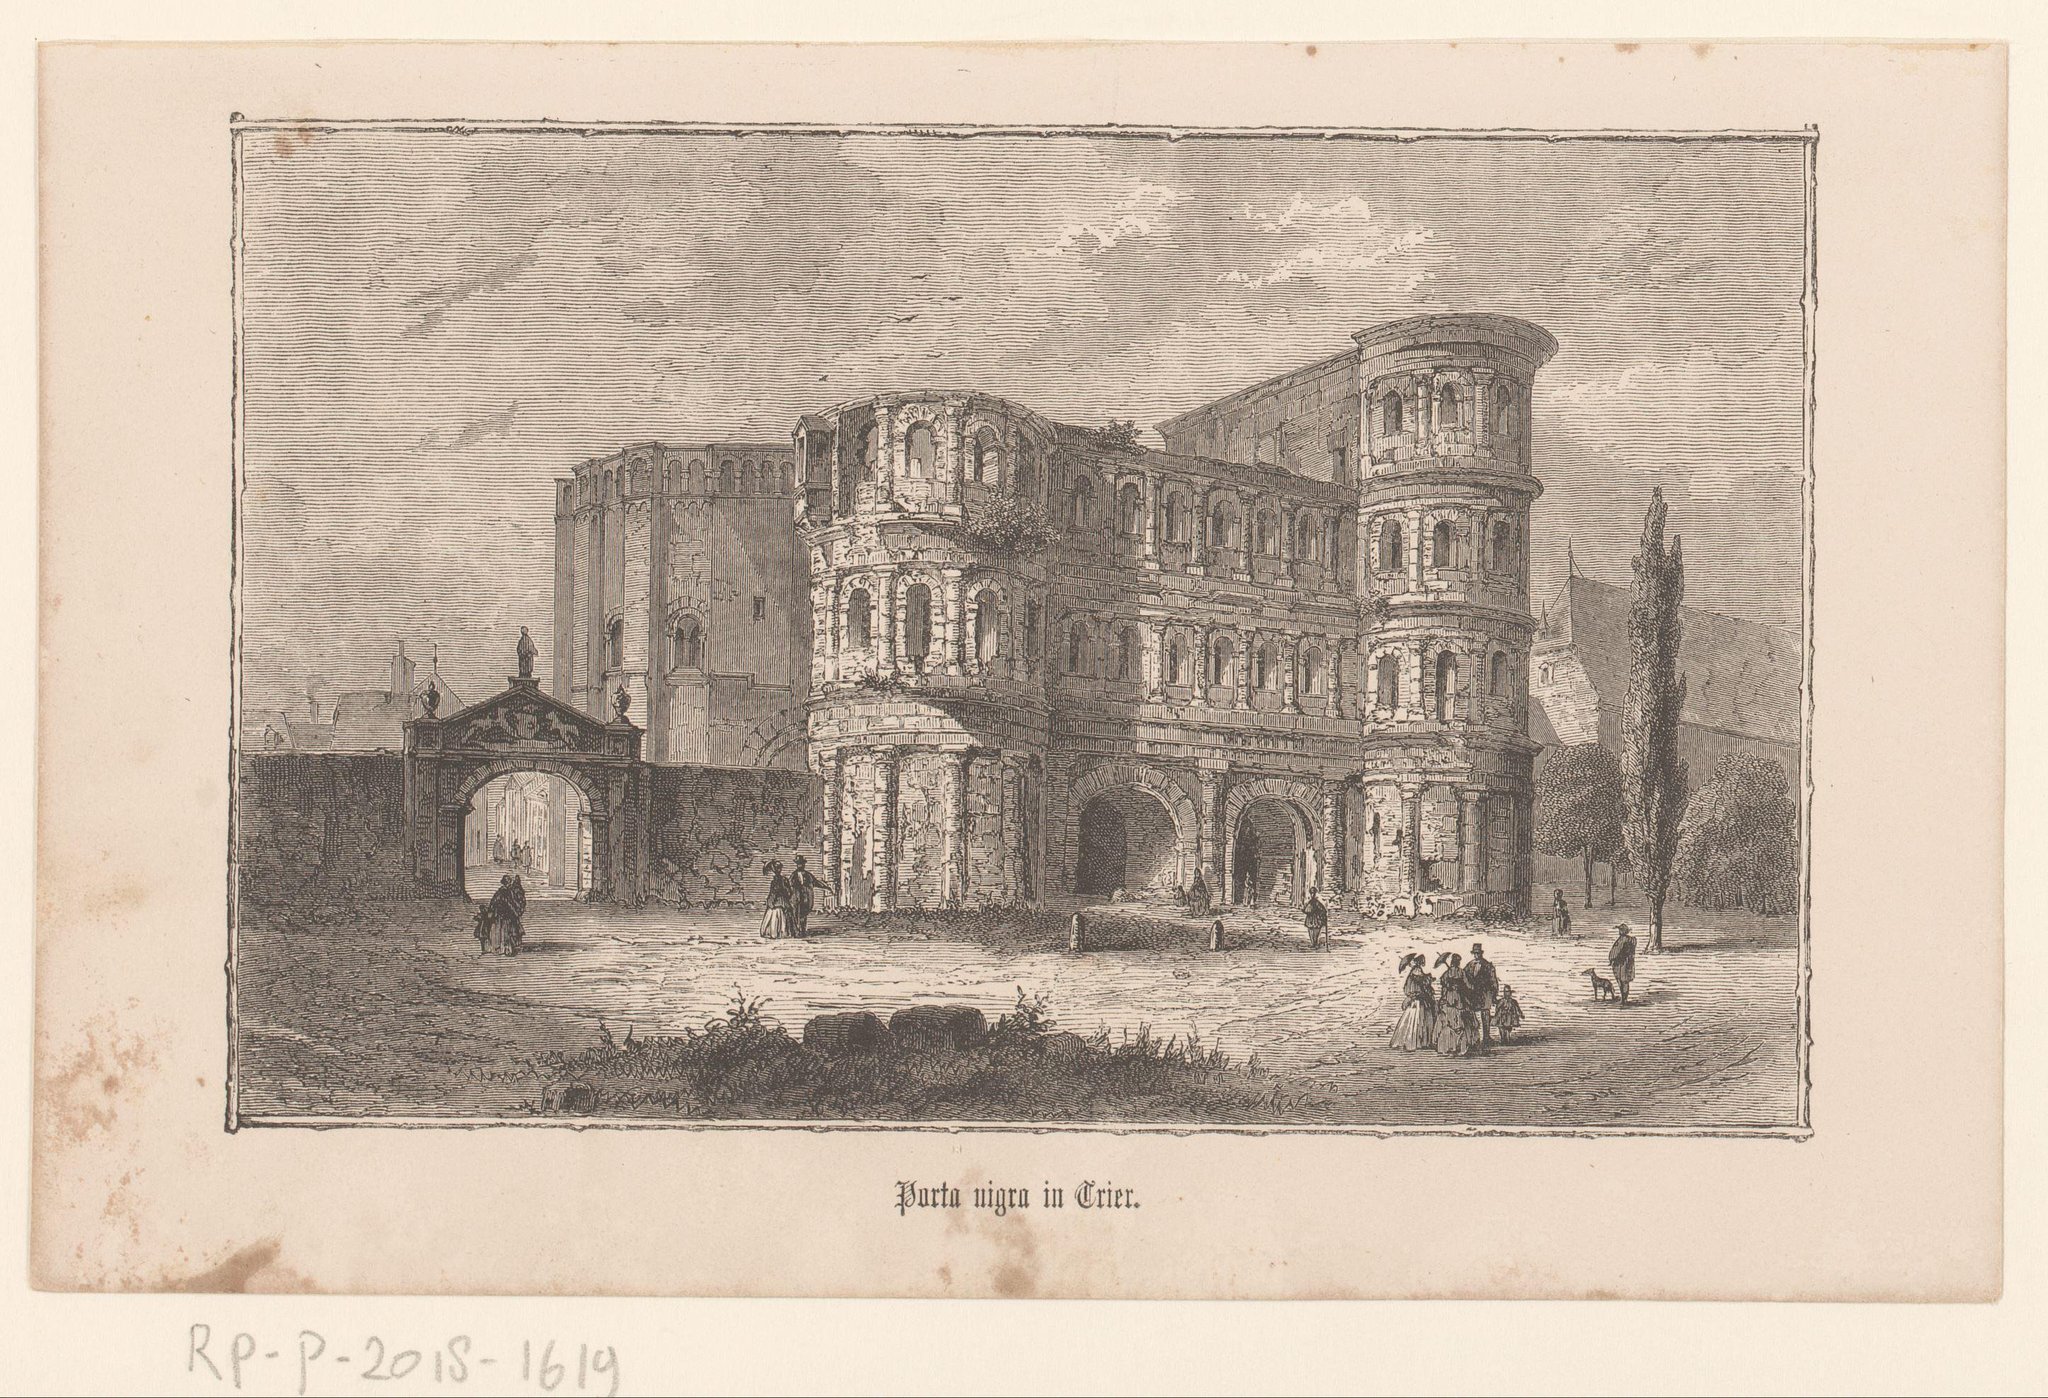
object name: print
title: Gezicht op de Porta Nigra, te Trier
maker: Anonymous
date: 1800-1899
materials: paper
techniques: engraving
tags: city-gate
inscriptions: collector's mark: Lugt 2228